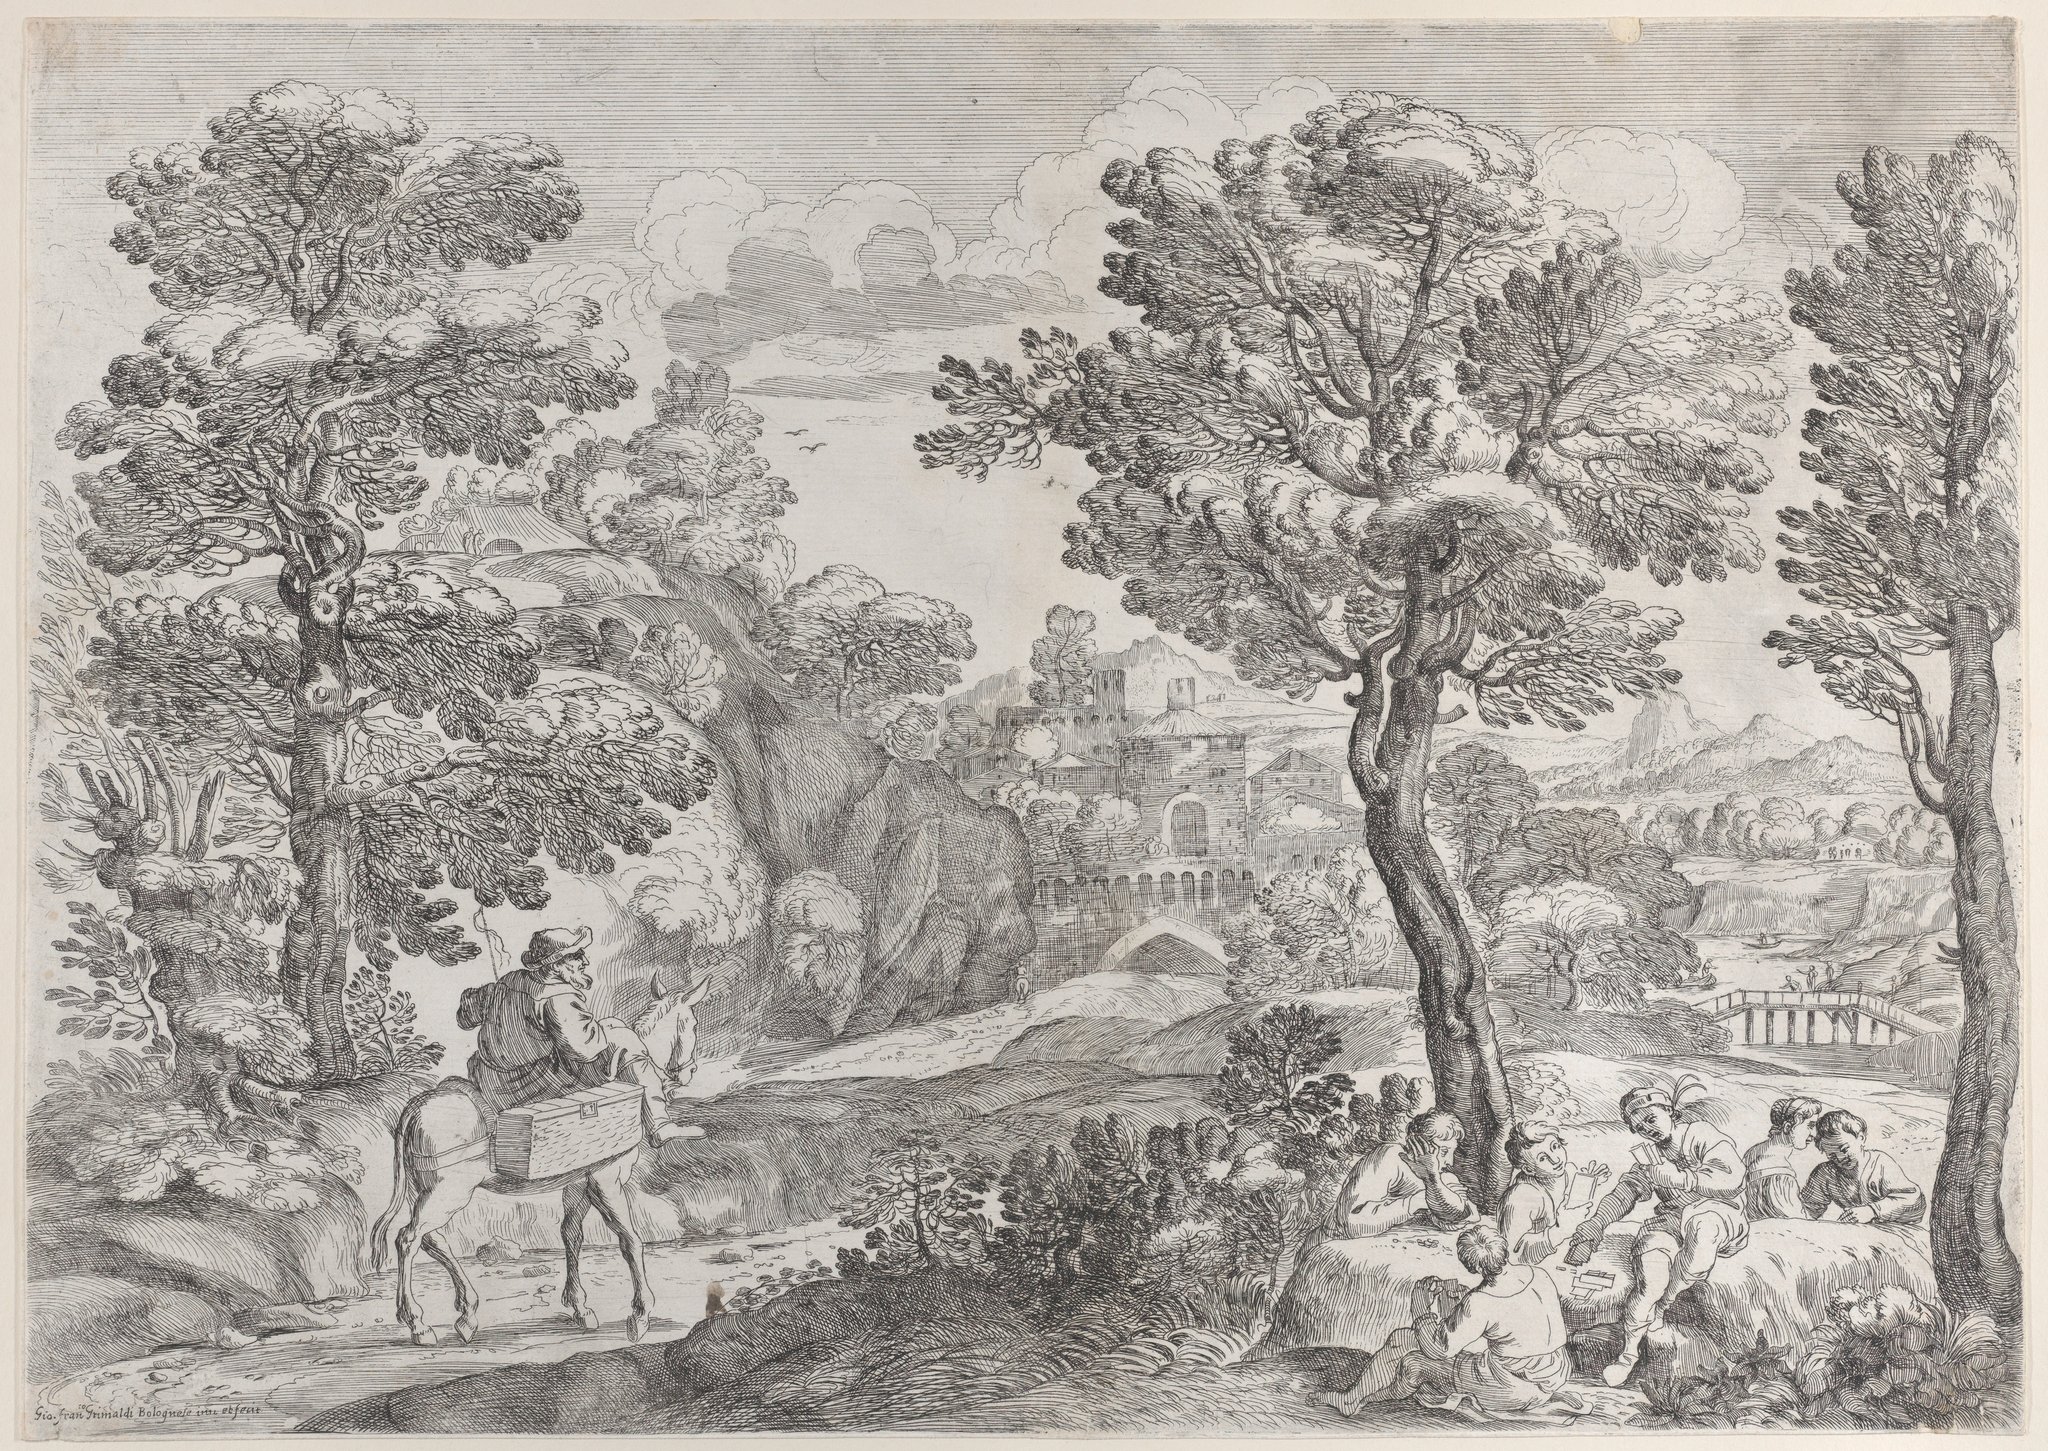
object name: print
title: A group of people playing cards at right and a man on horseback at left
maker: giovanni francesco grimaldi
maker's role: artist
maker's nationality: italian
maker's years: 1606-1680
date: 1626-1680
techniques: etching